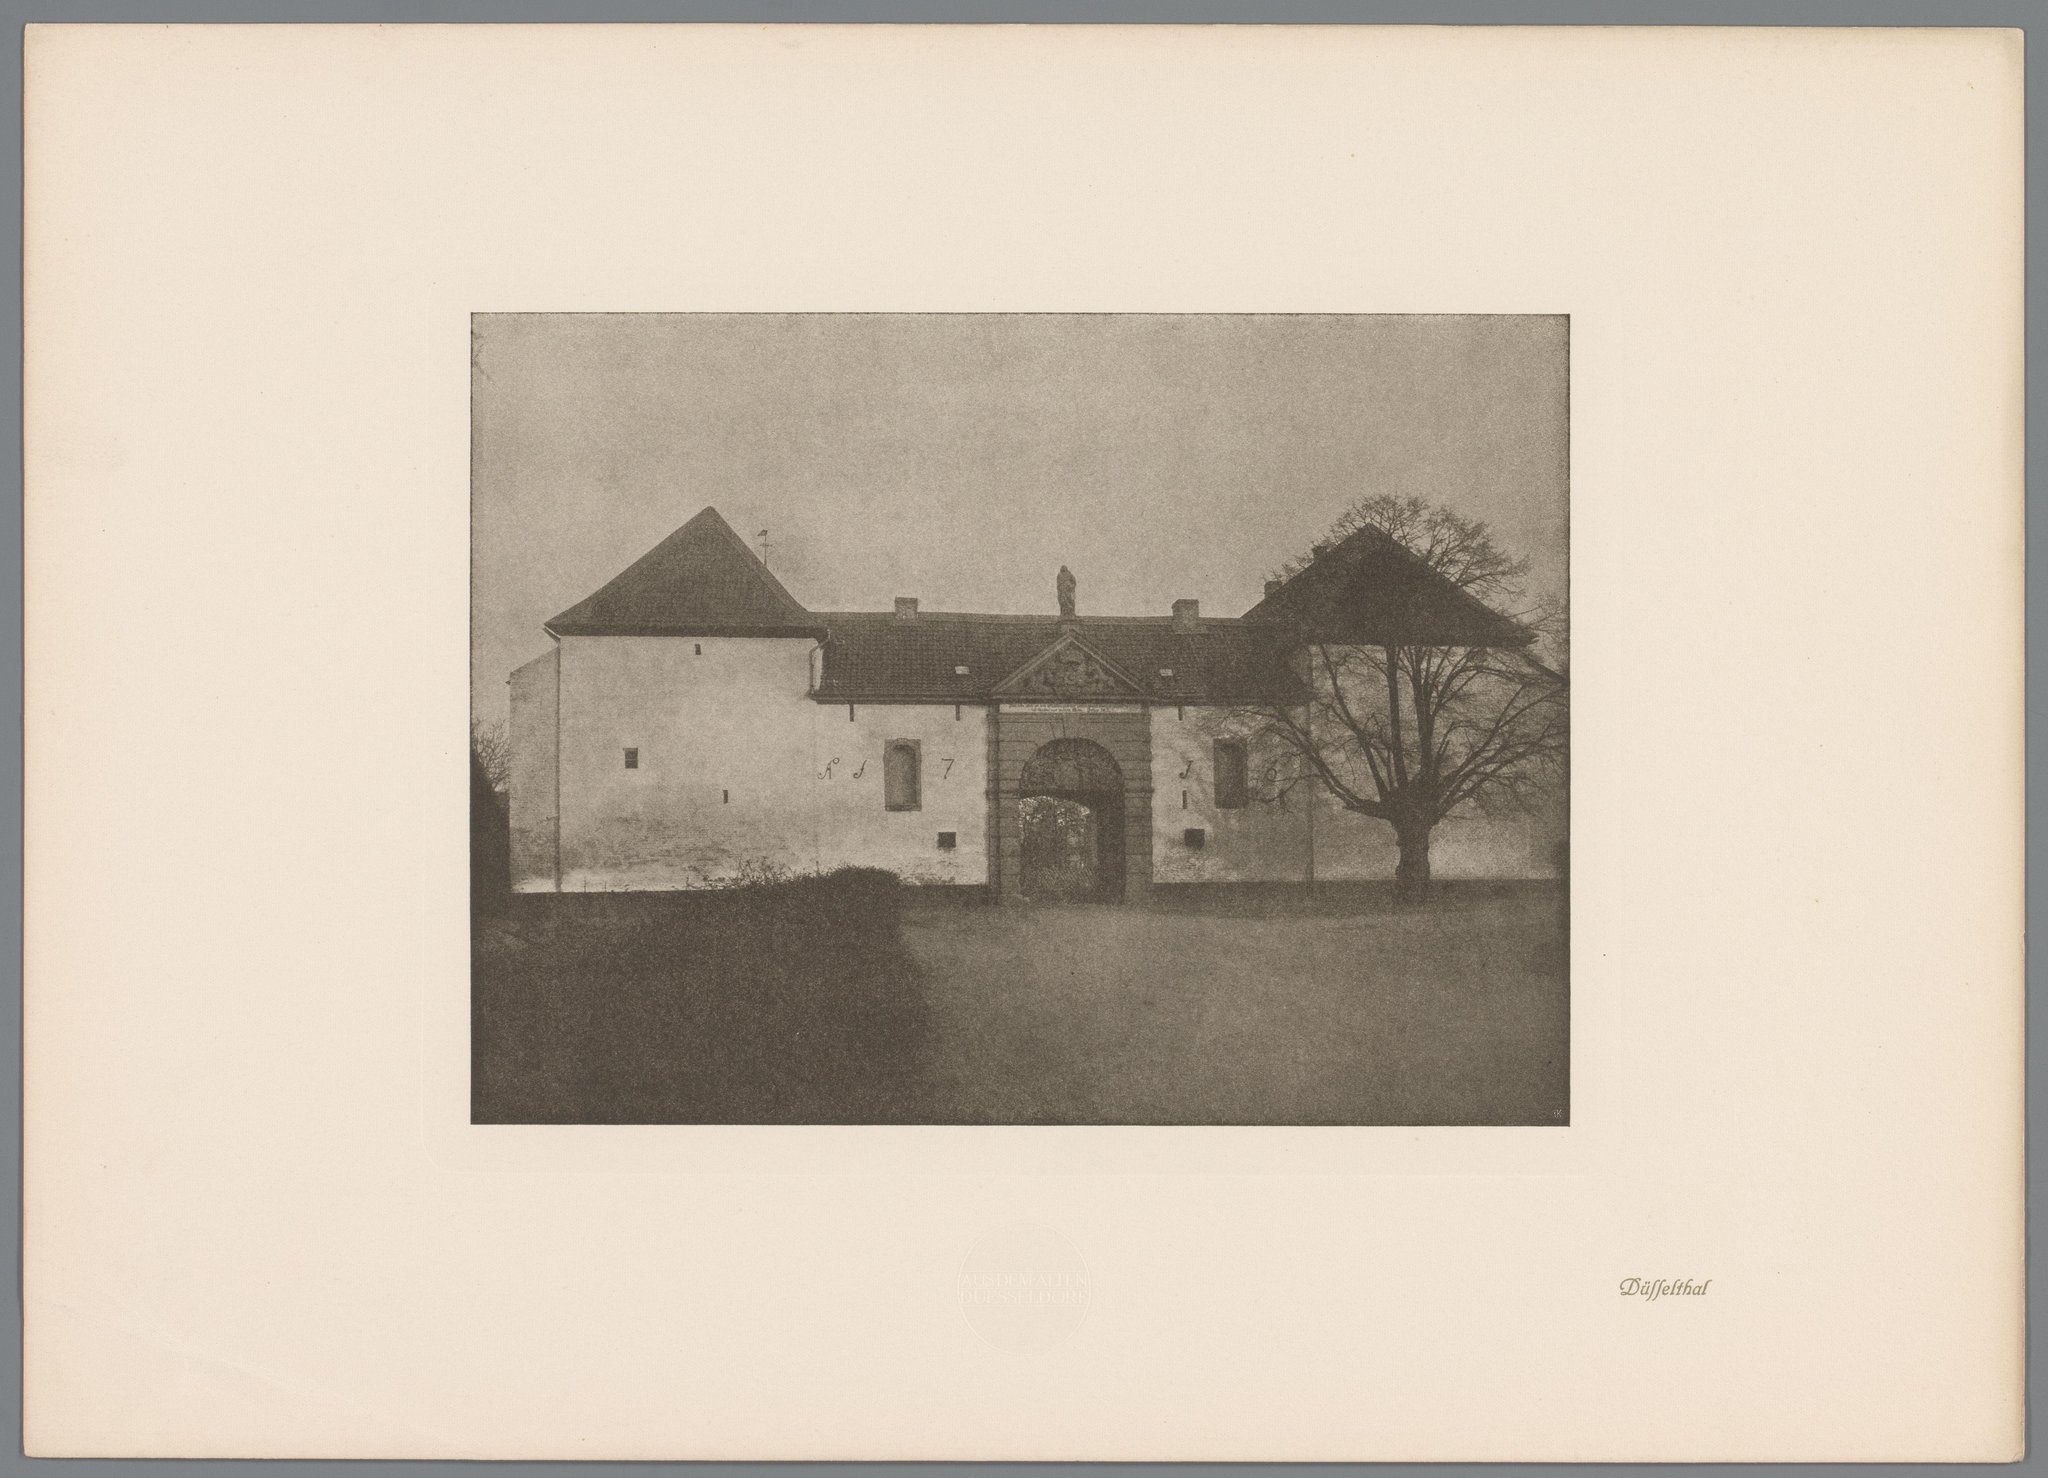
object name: page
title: Reproductie van een gomdruk van het poortgebouw van de abdij van Düsselthal in Düsseldorf door Erwin Quedenfeldt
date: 1902-1907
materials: paper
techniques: autotype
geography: offenbach am main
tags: abbey, monastery, convent ~ roman catholic church, gate, entrance